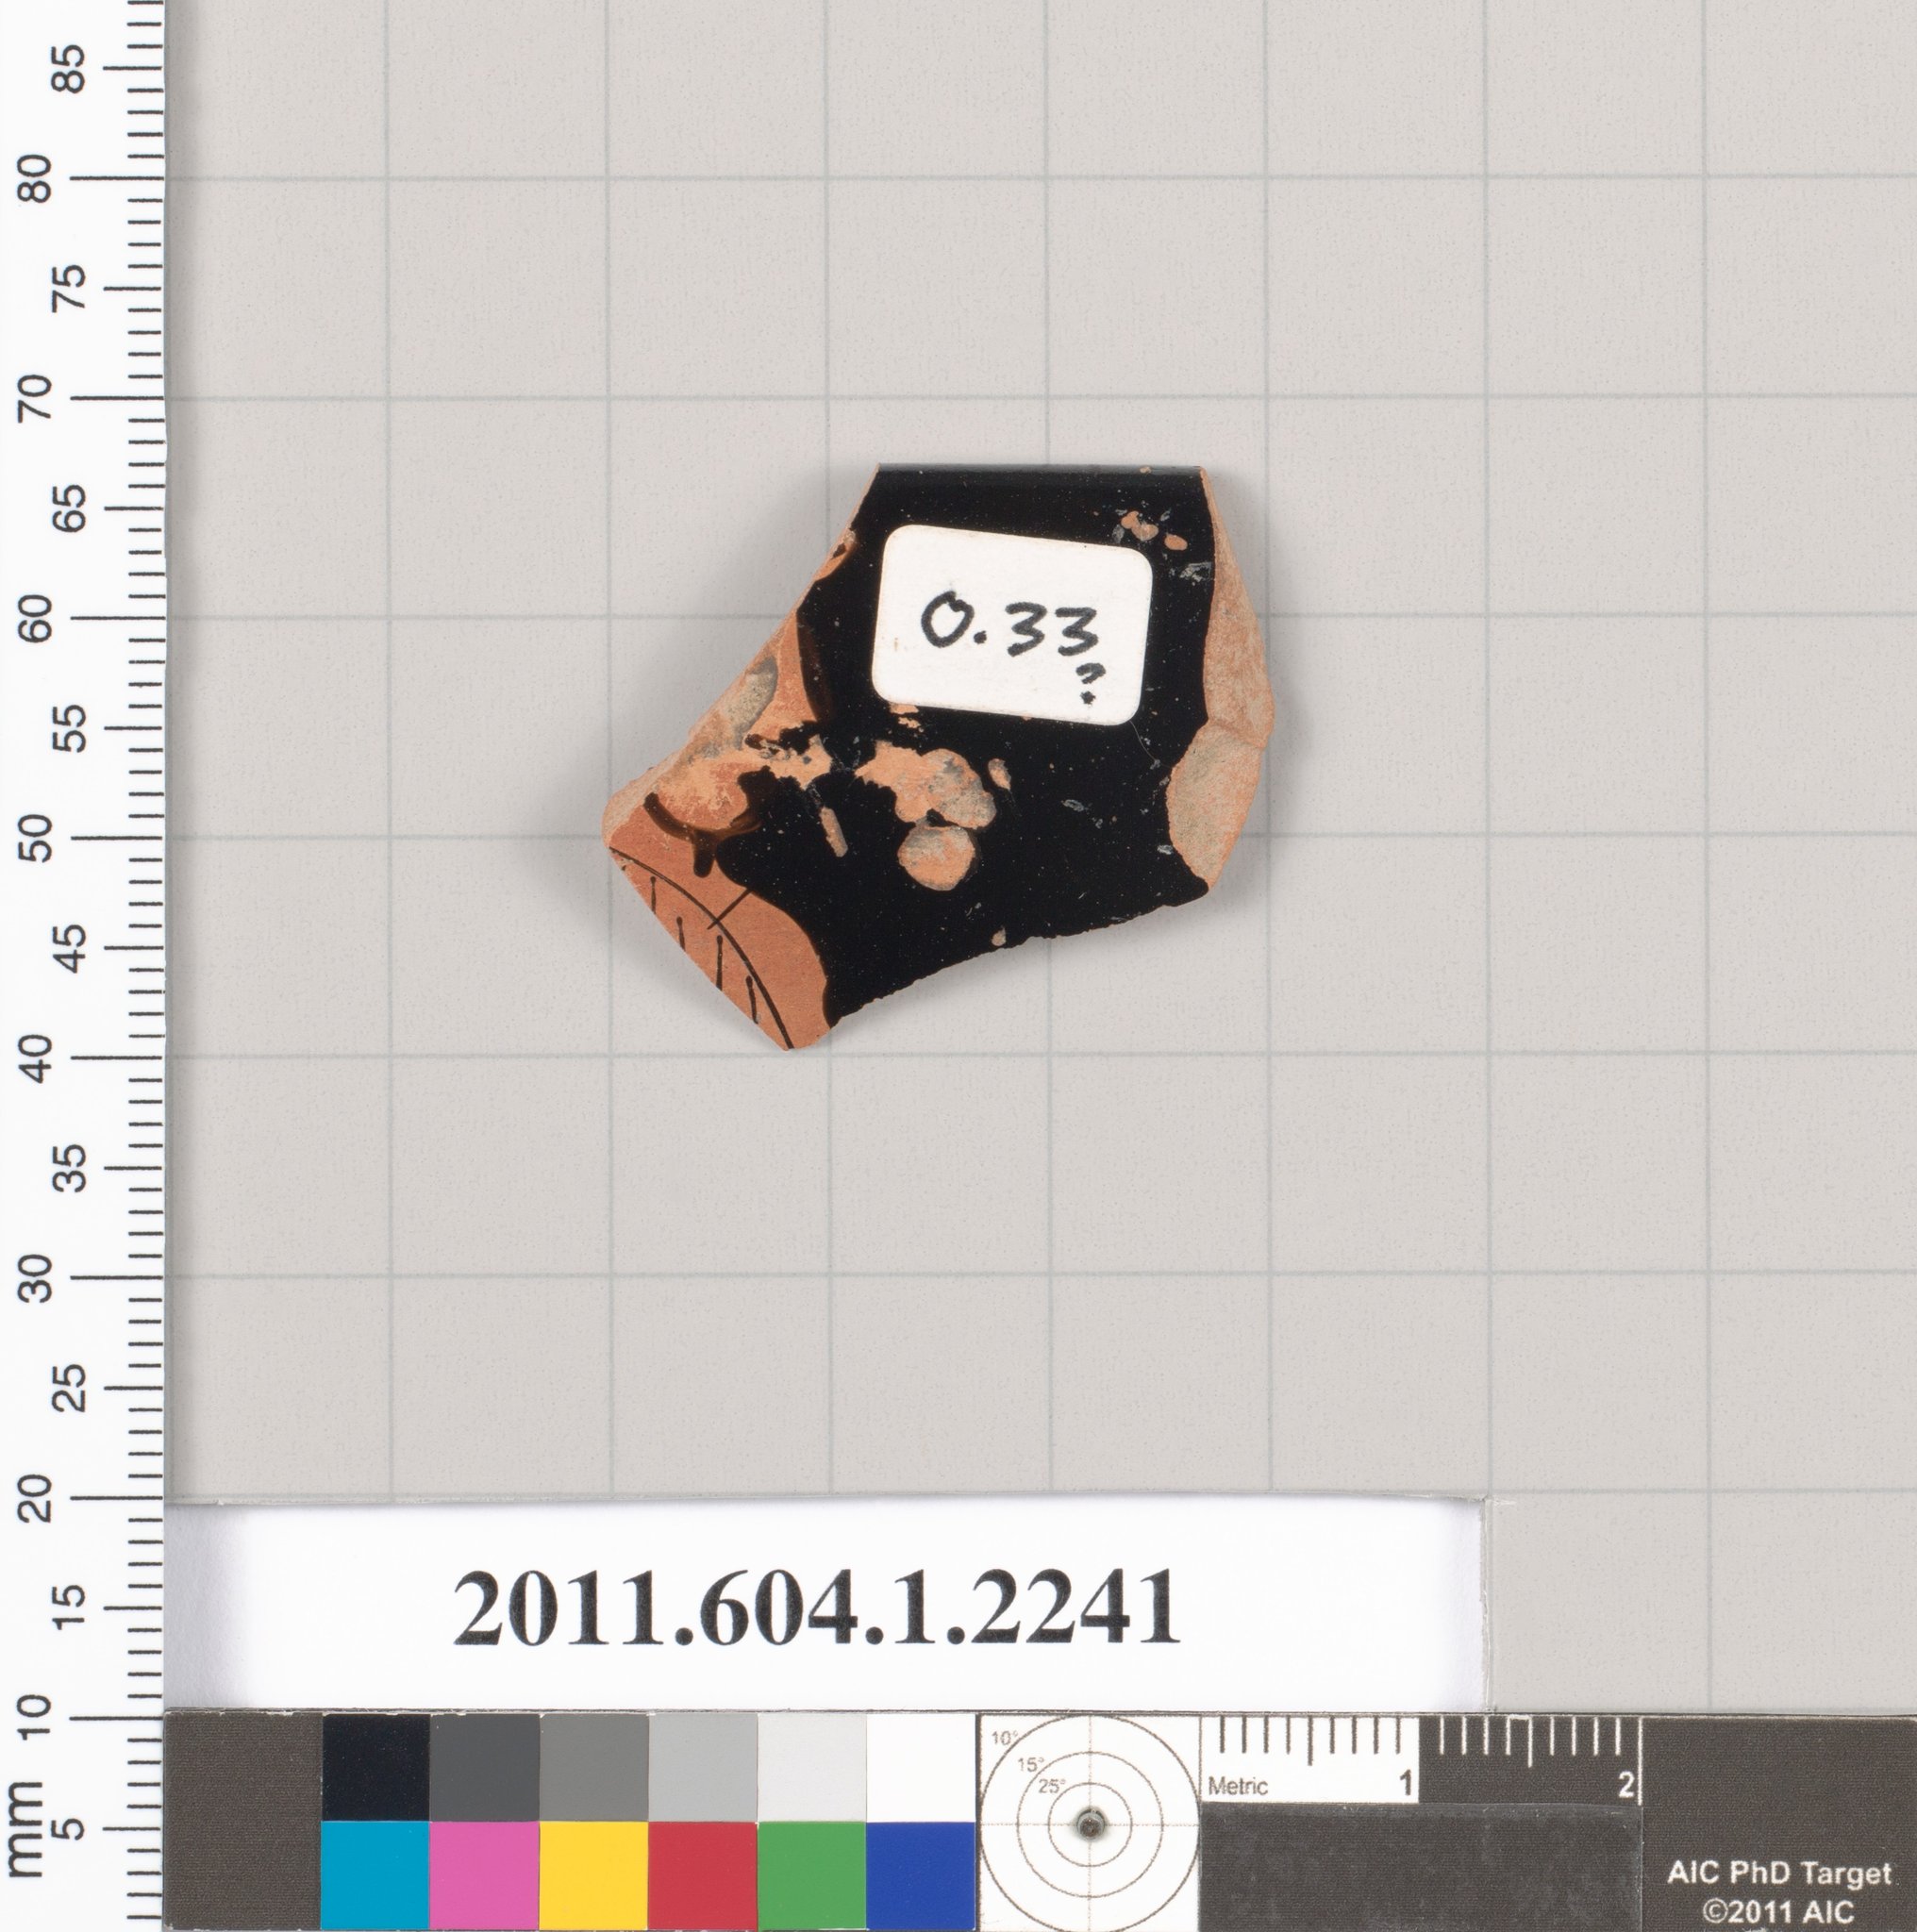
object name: kylix fragment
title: Terracotta rim fragment of a kylix (drinking cup)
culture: greek, attic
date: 475-451 BCE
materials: terracotta